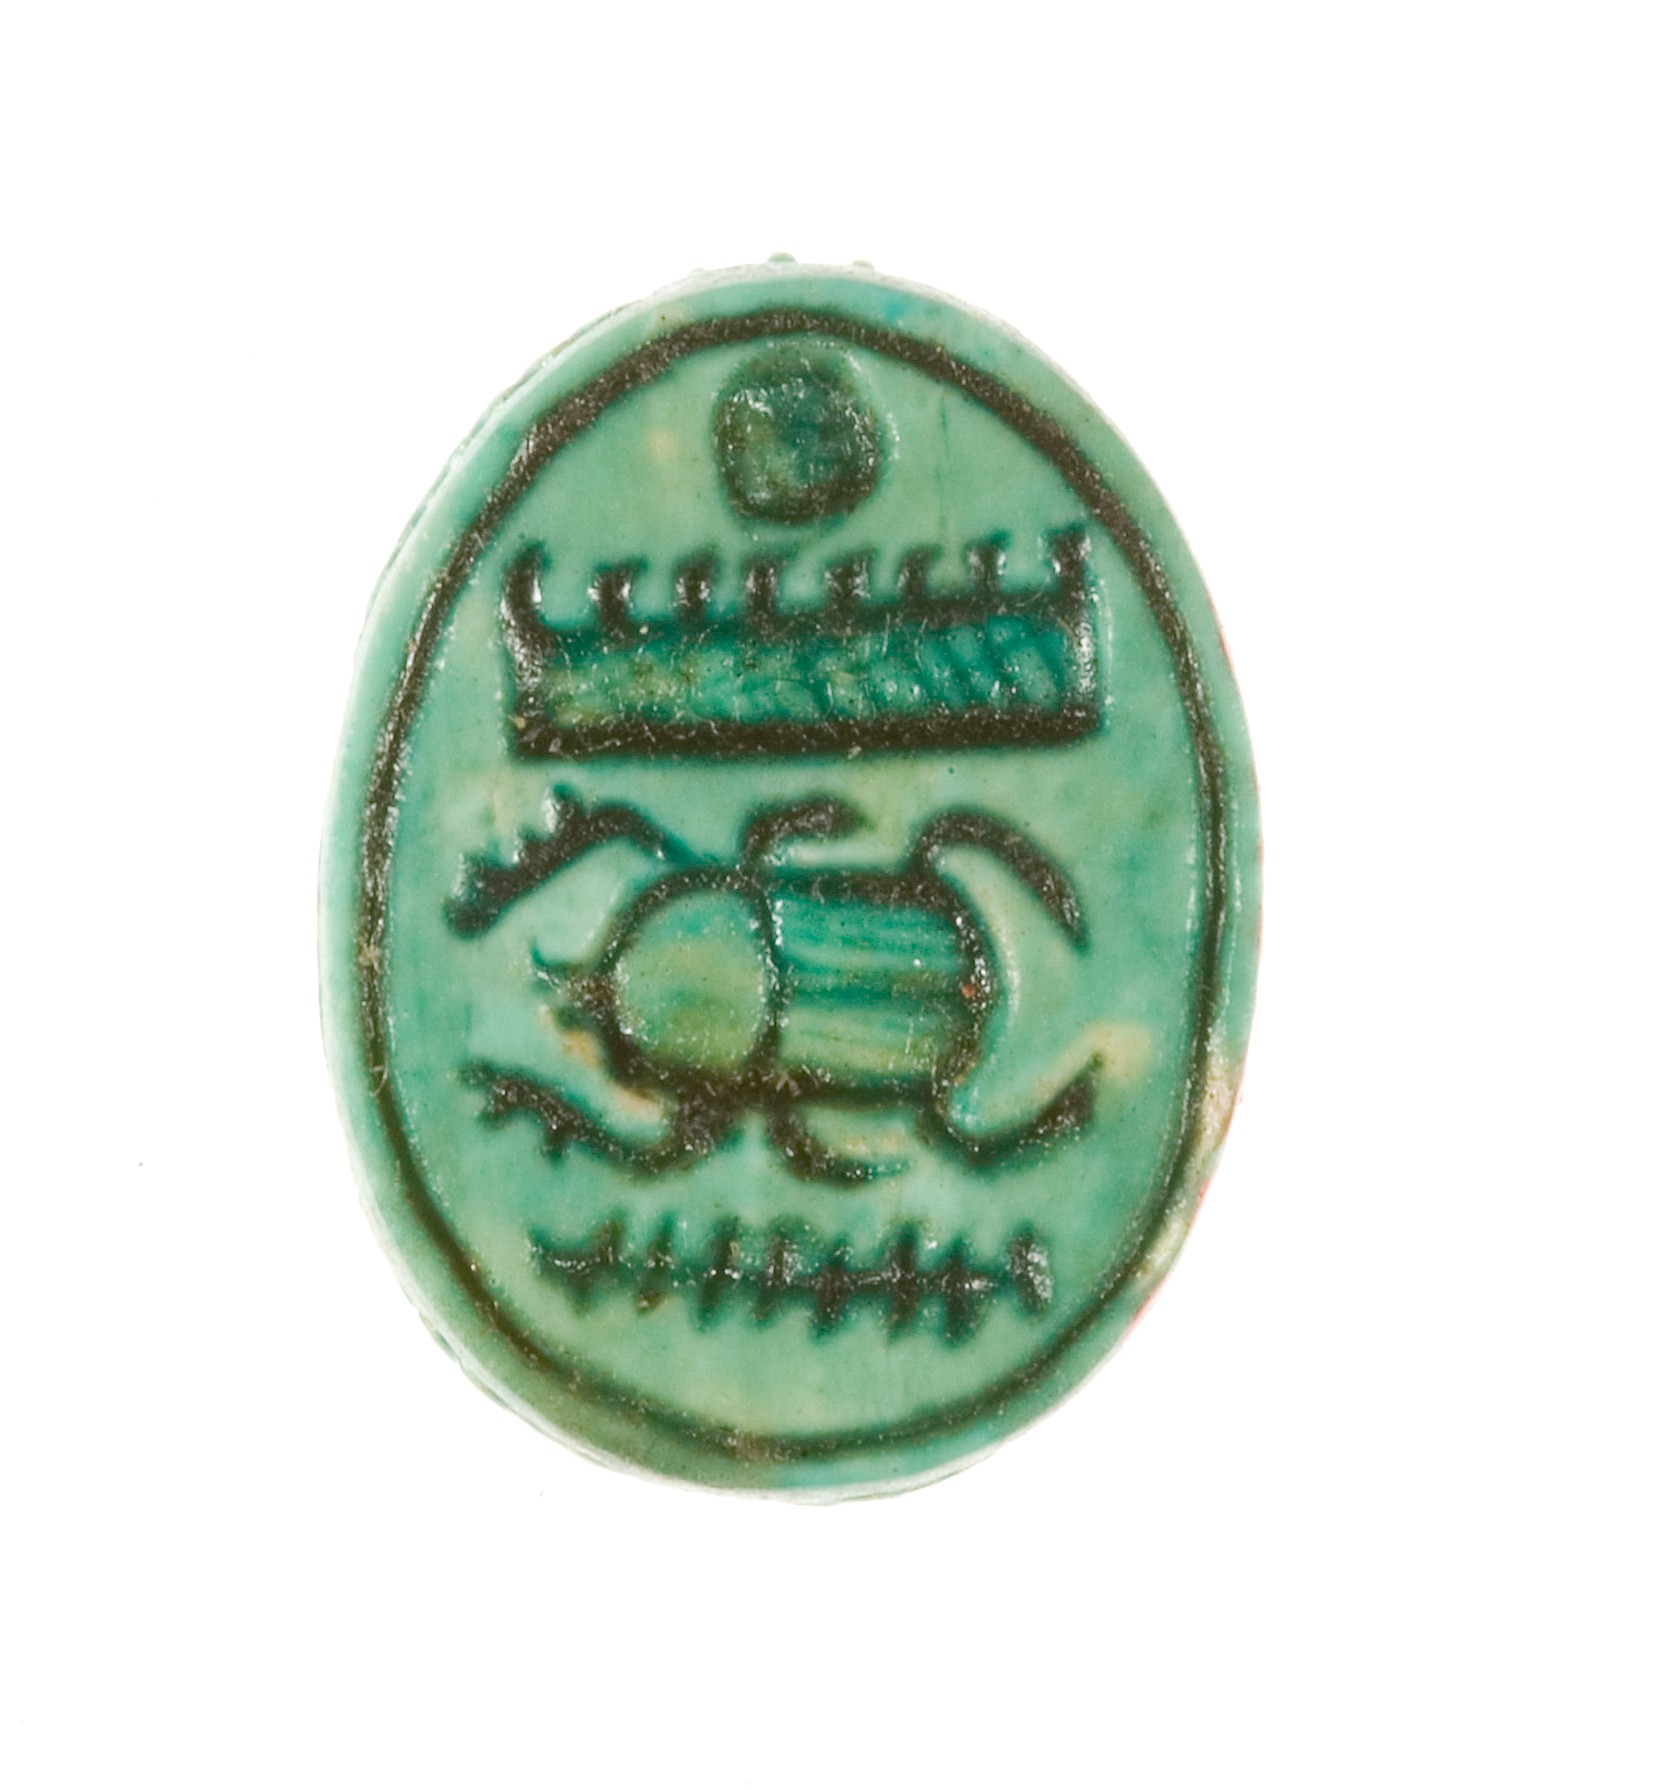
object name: scarab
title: Scarab Inscribed for Menkheperenre (Thutmose III)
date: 1479-1458 BCE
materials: stone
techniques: glazing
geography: egypt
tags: scarabs